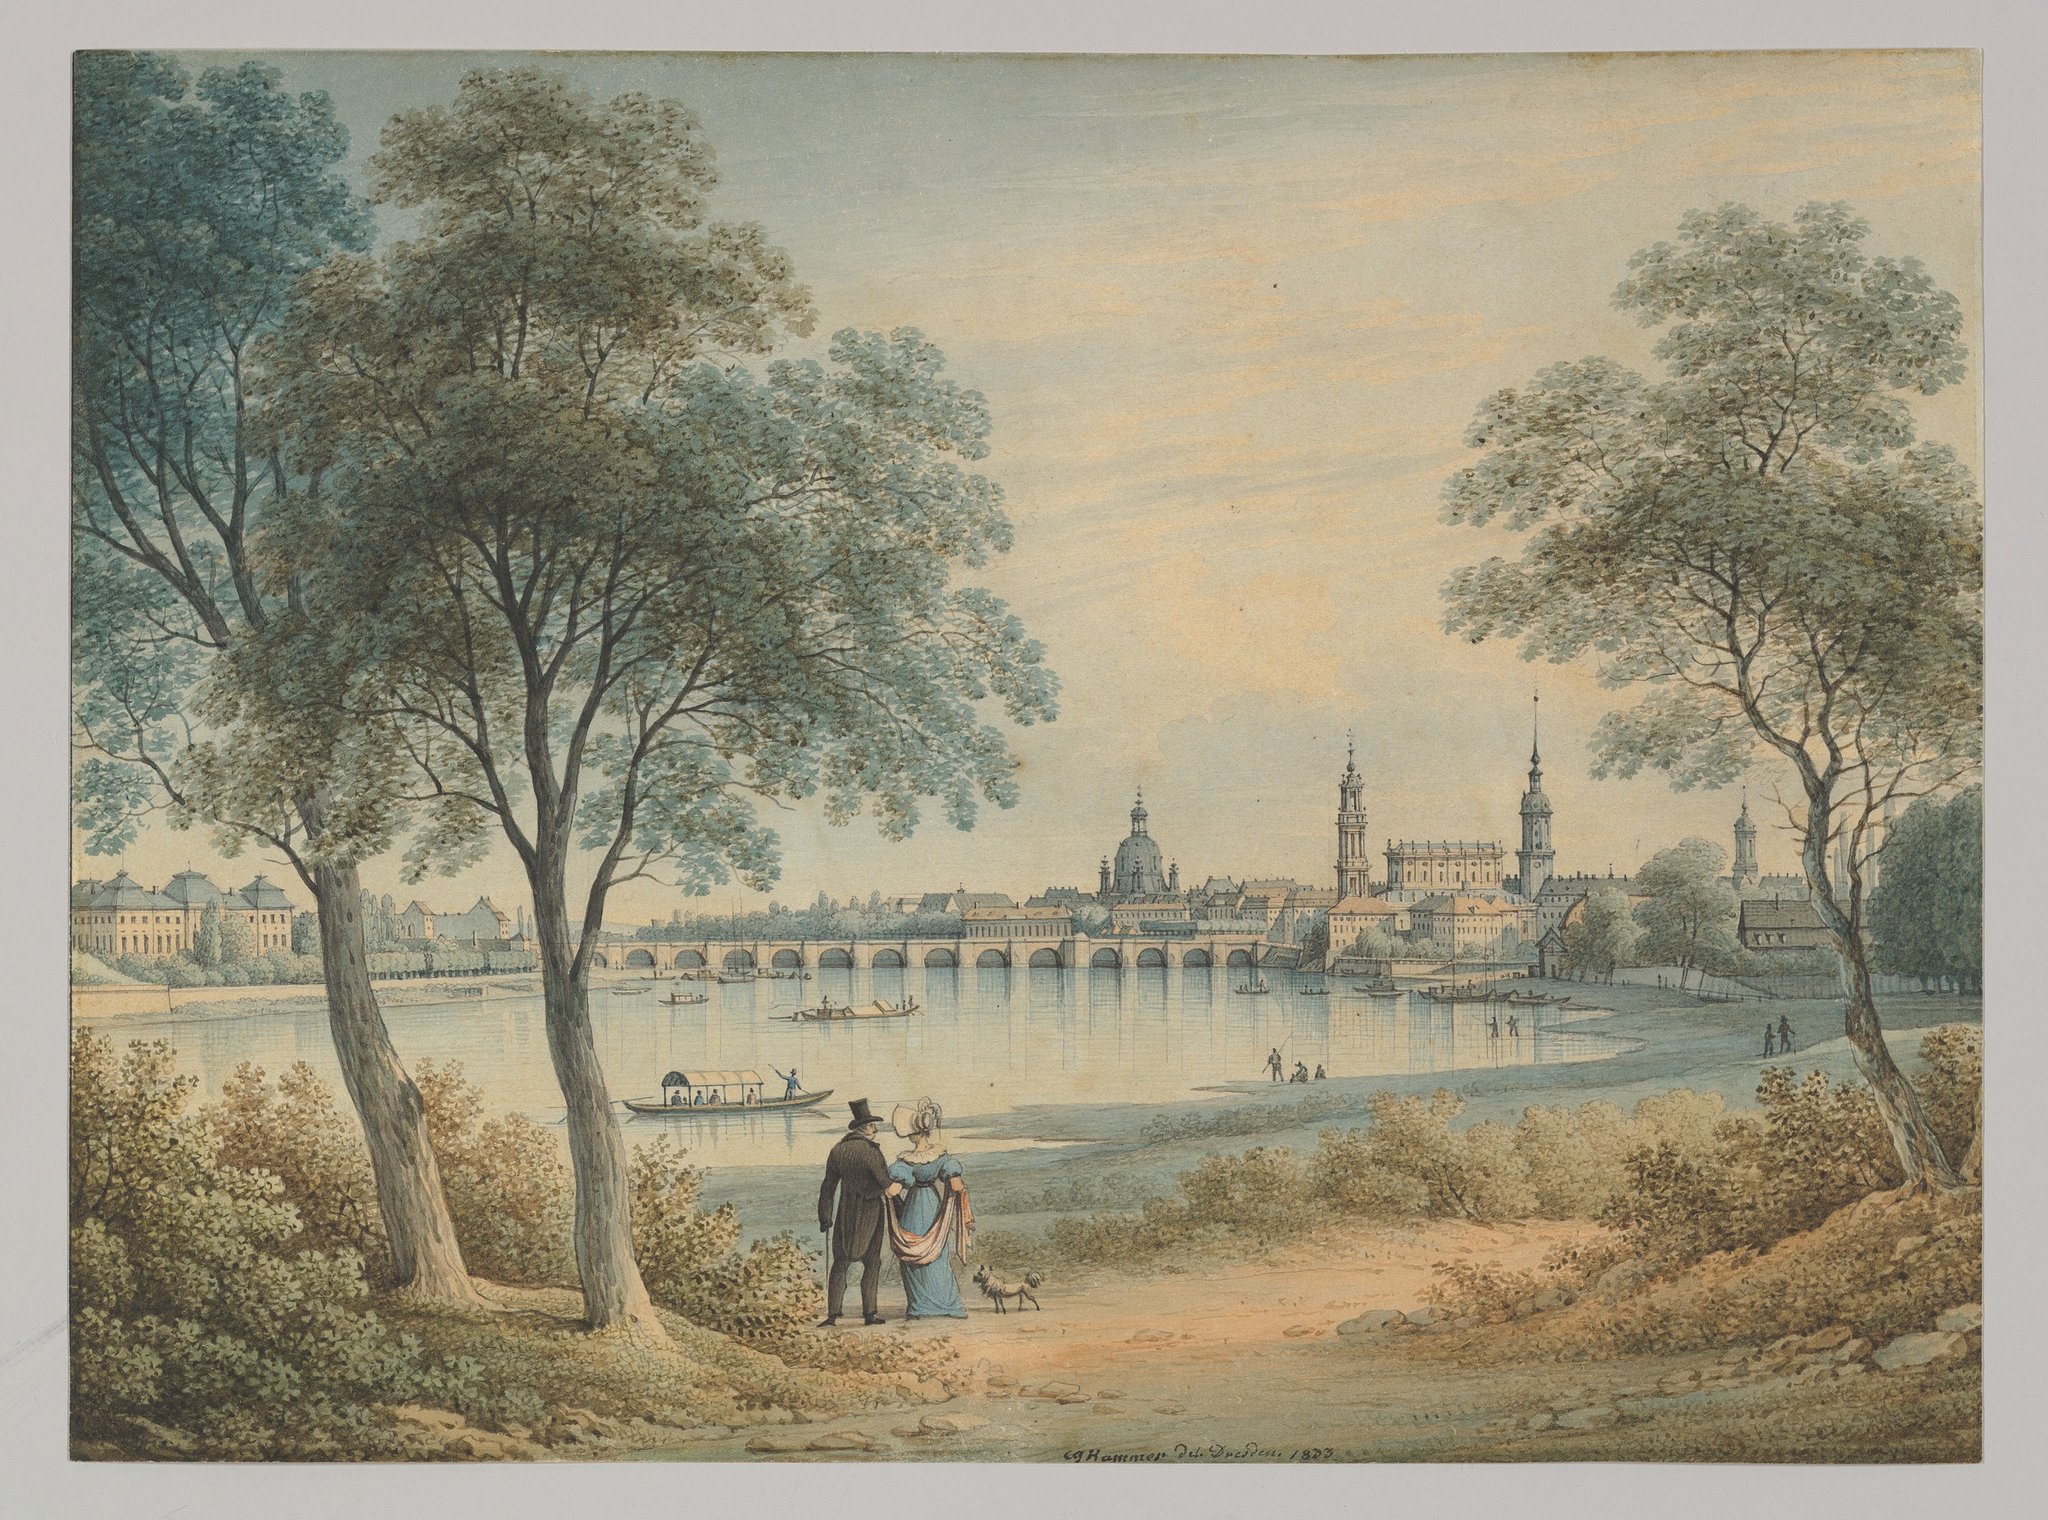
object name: drawing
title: View of Dresden from the West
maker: christian gottlob hammer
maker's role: artist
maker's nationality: german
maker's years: 1779-1864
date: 1833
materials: watercolor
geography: germany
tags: cities,bridges,men,women